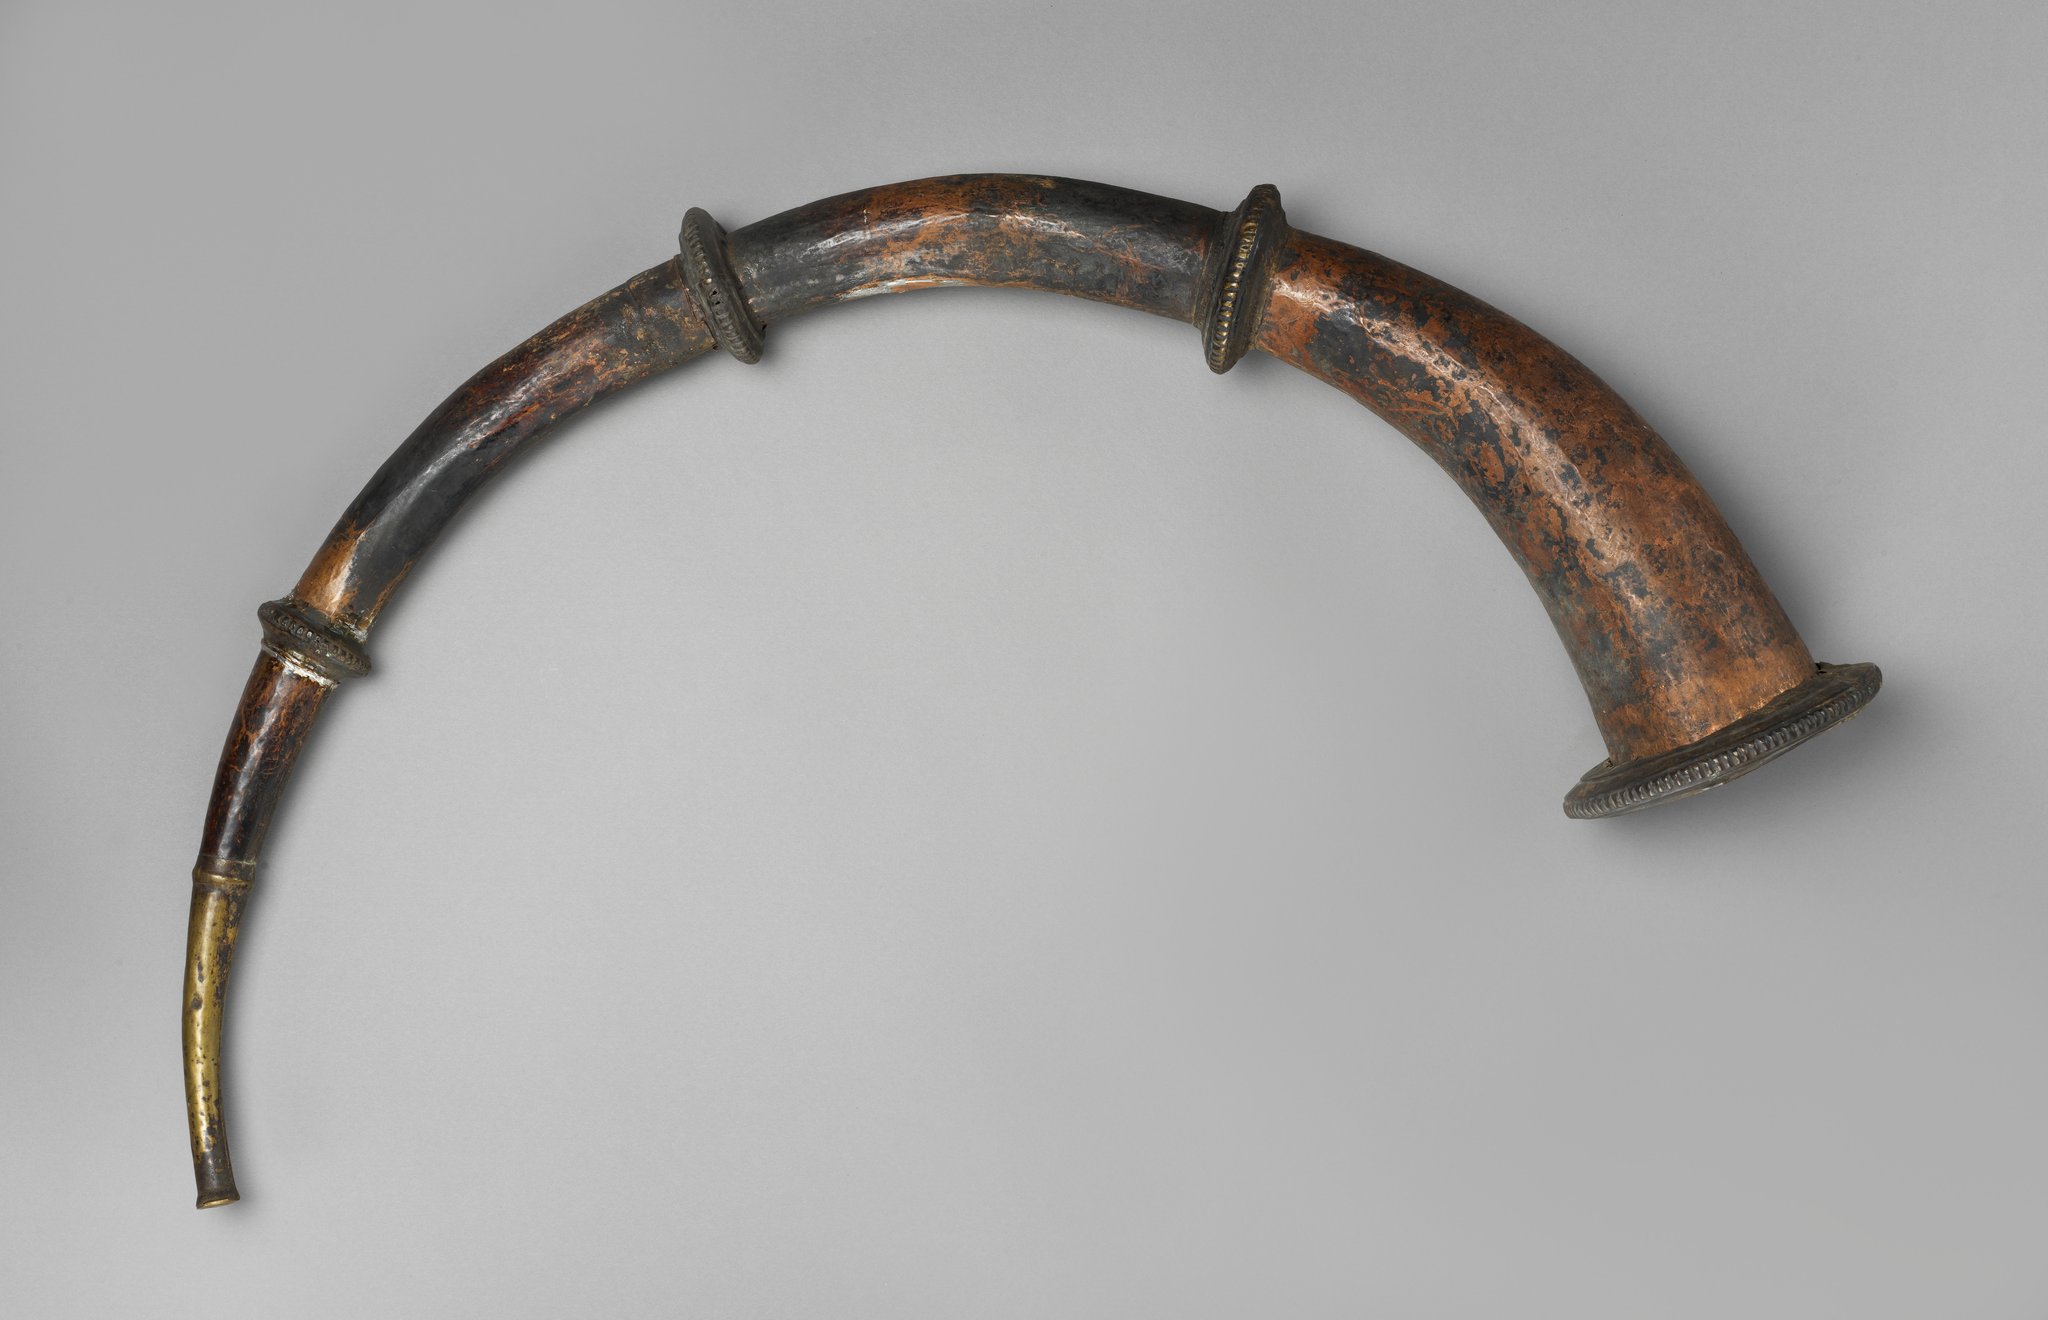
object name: narsĩngā narsĩngā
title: Narsĩngā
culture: nepalese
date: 1801-1900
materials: copper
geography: nepal